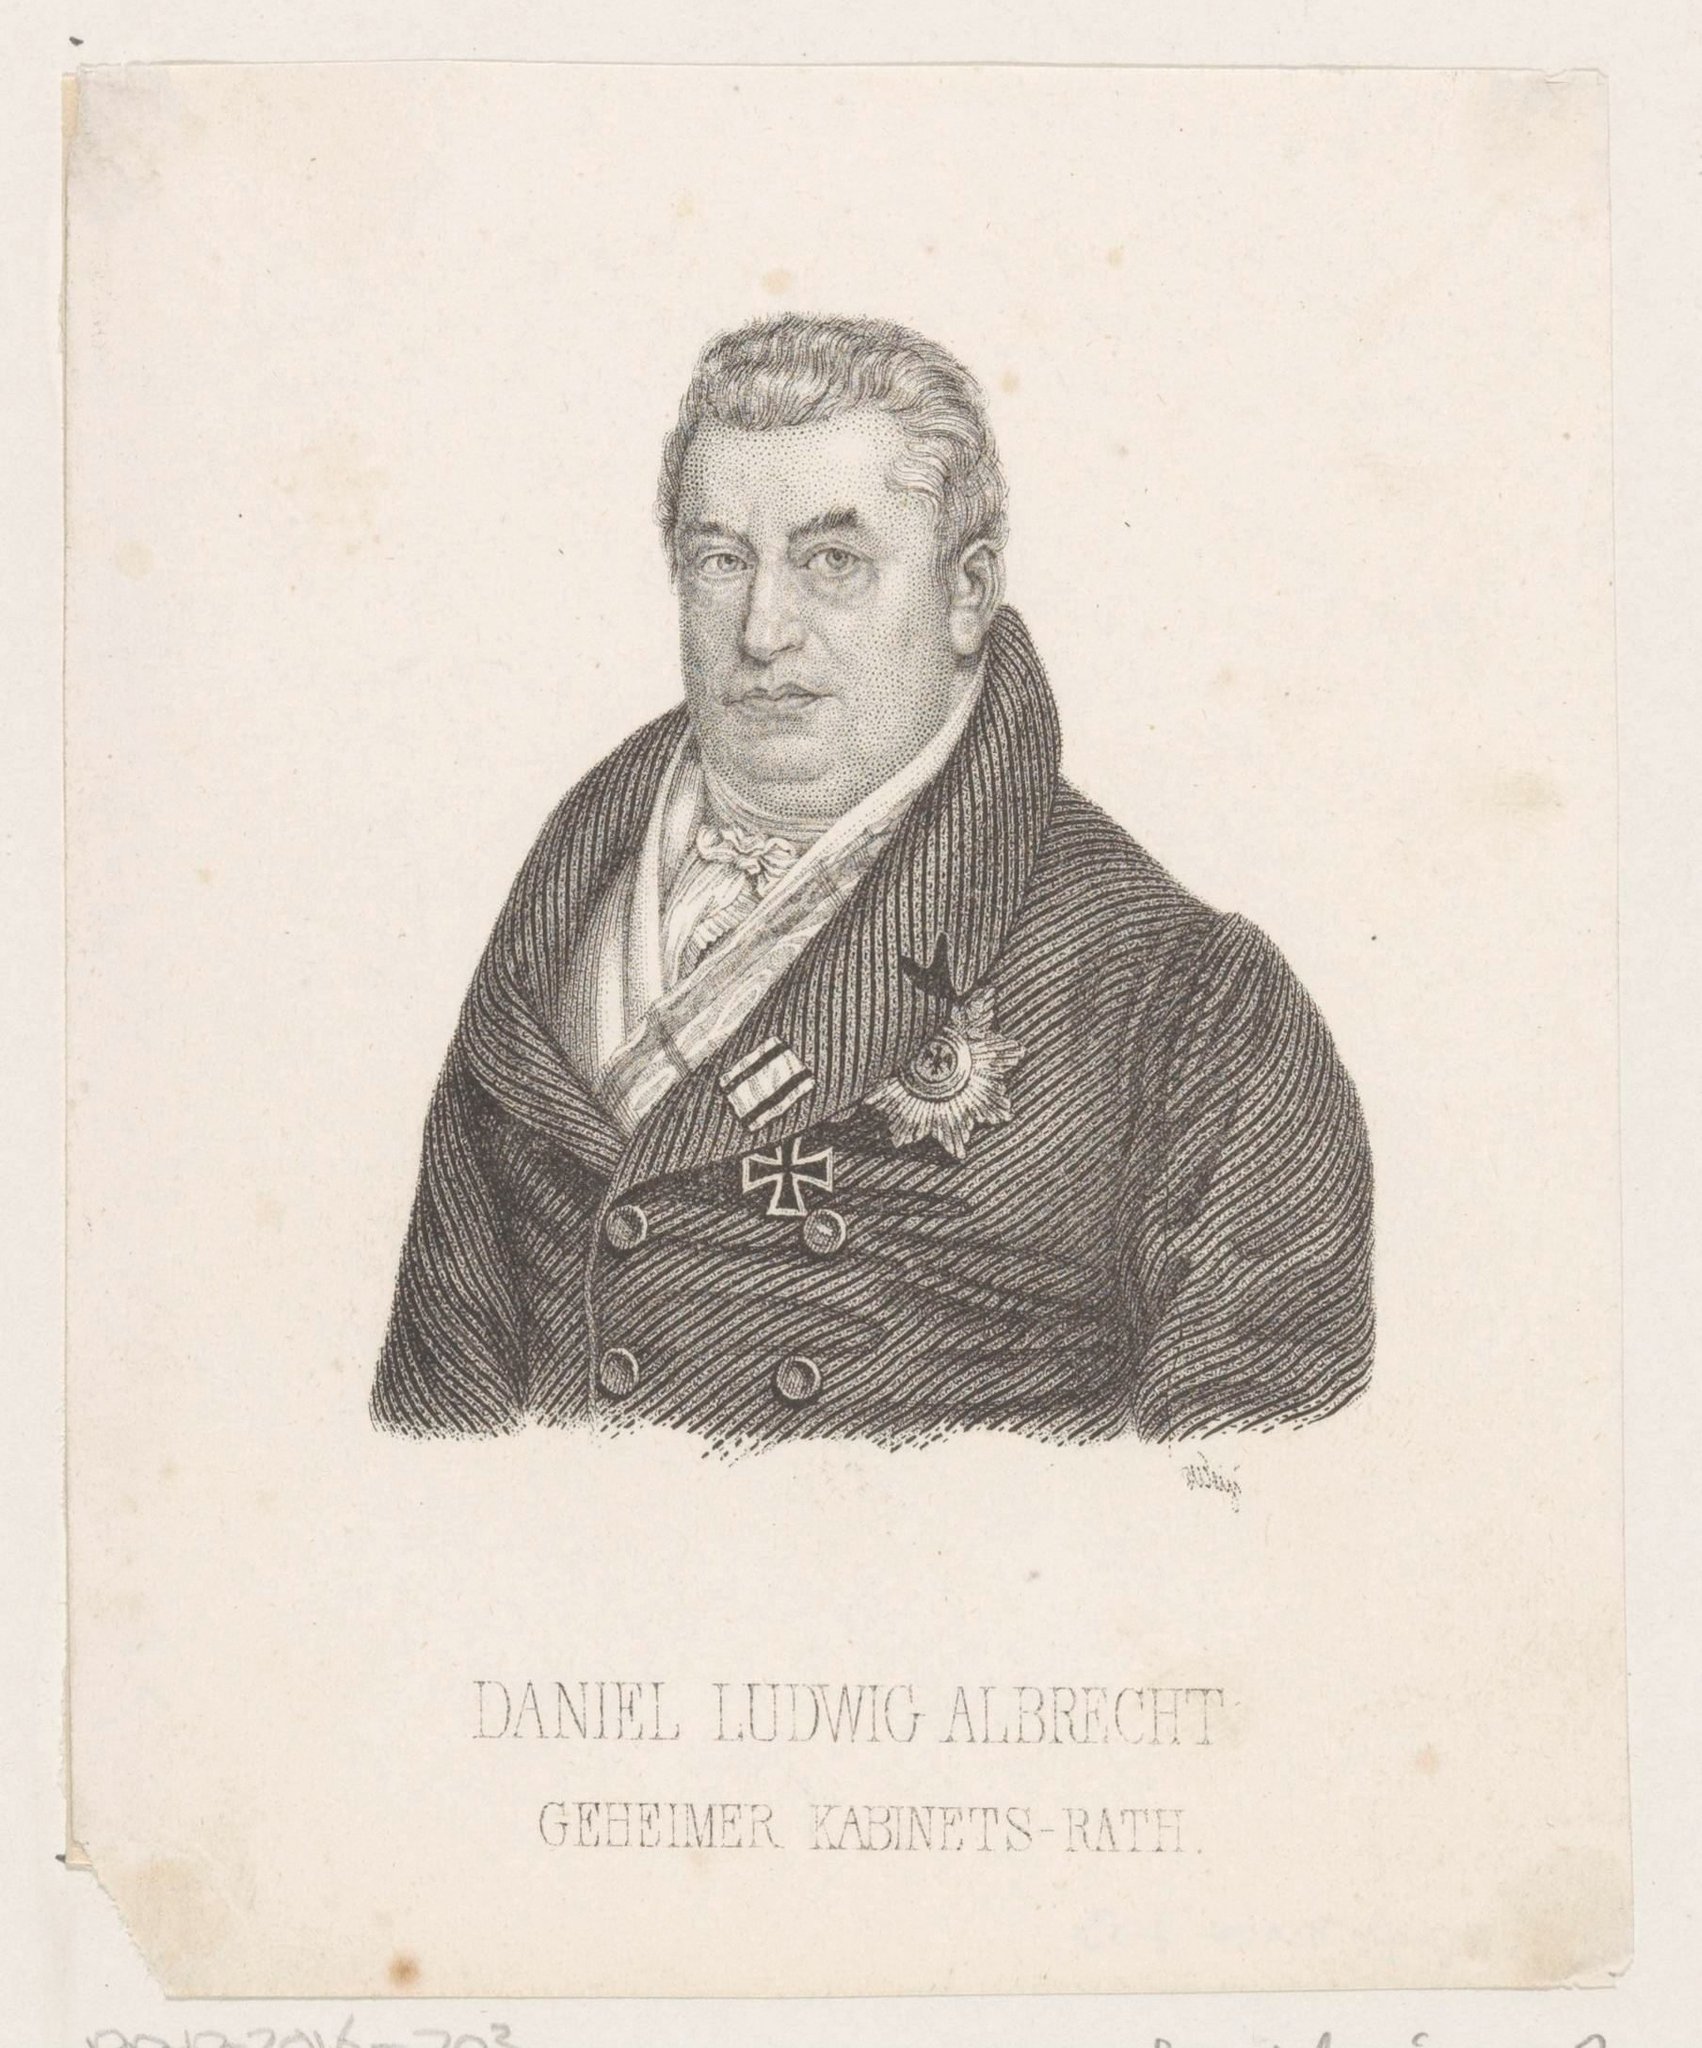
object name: print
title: Portret van Daniel Ludwig Albrecht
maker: Anonymous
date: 1800-1899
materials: paper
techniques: etching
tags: daniel ludwig albrecht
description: Portret van Daniel Ludwig Albrecht. In de ondermarge zijn naam en een regel Duitse tekst.